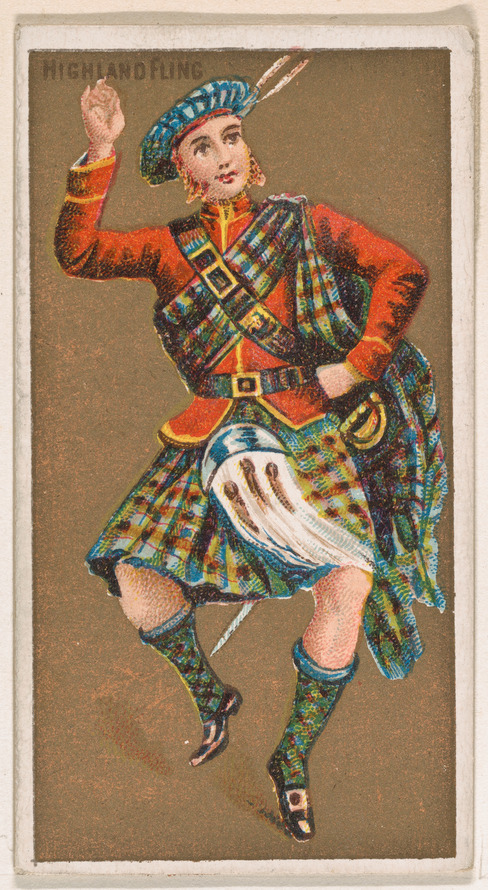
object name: print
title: Highland Fling, from National Dances (N225, Type 1) issued by Kinney Bros.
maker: kinney brothers tobacco company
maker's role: publisher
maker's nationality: american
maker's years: 1869-2011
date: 1889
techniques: color lithograph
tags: women,dancing,dancers